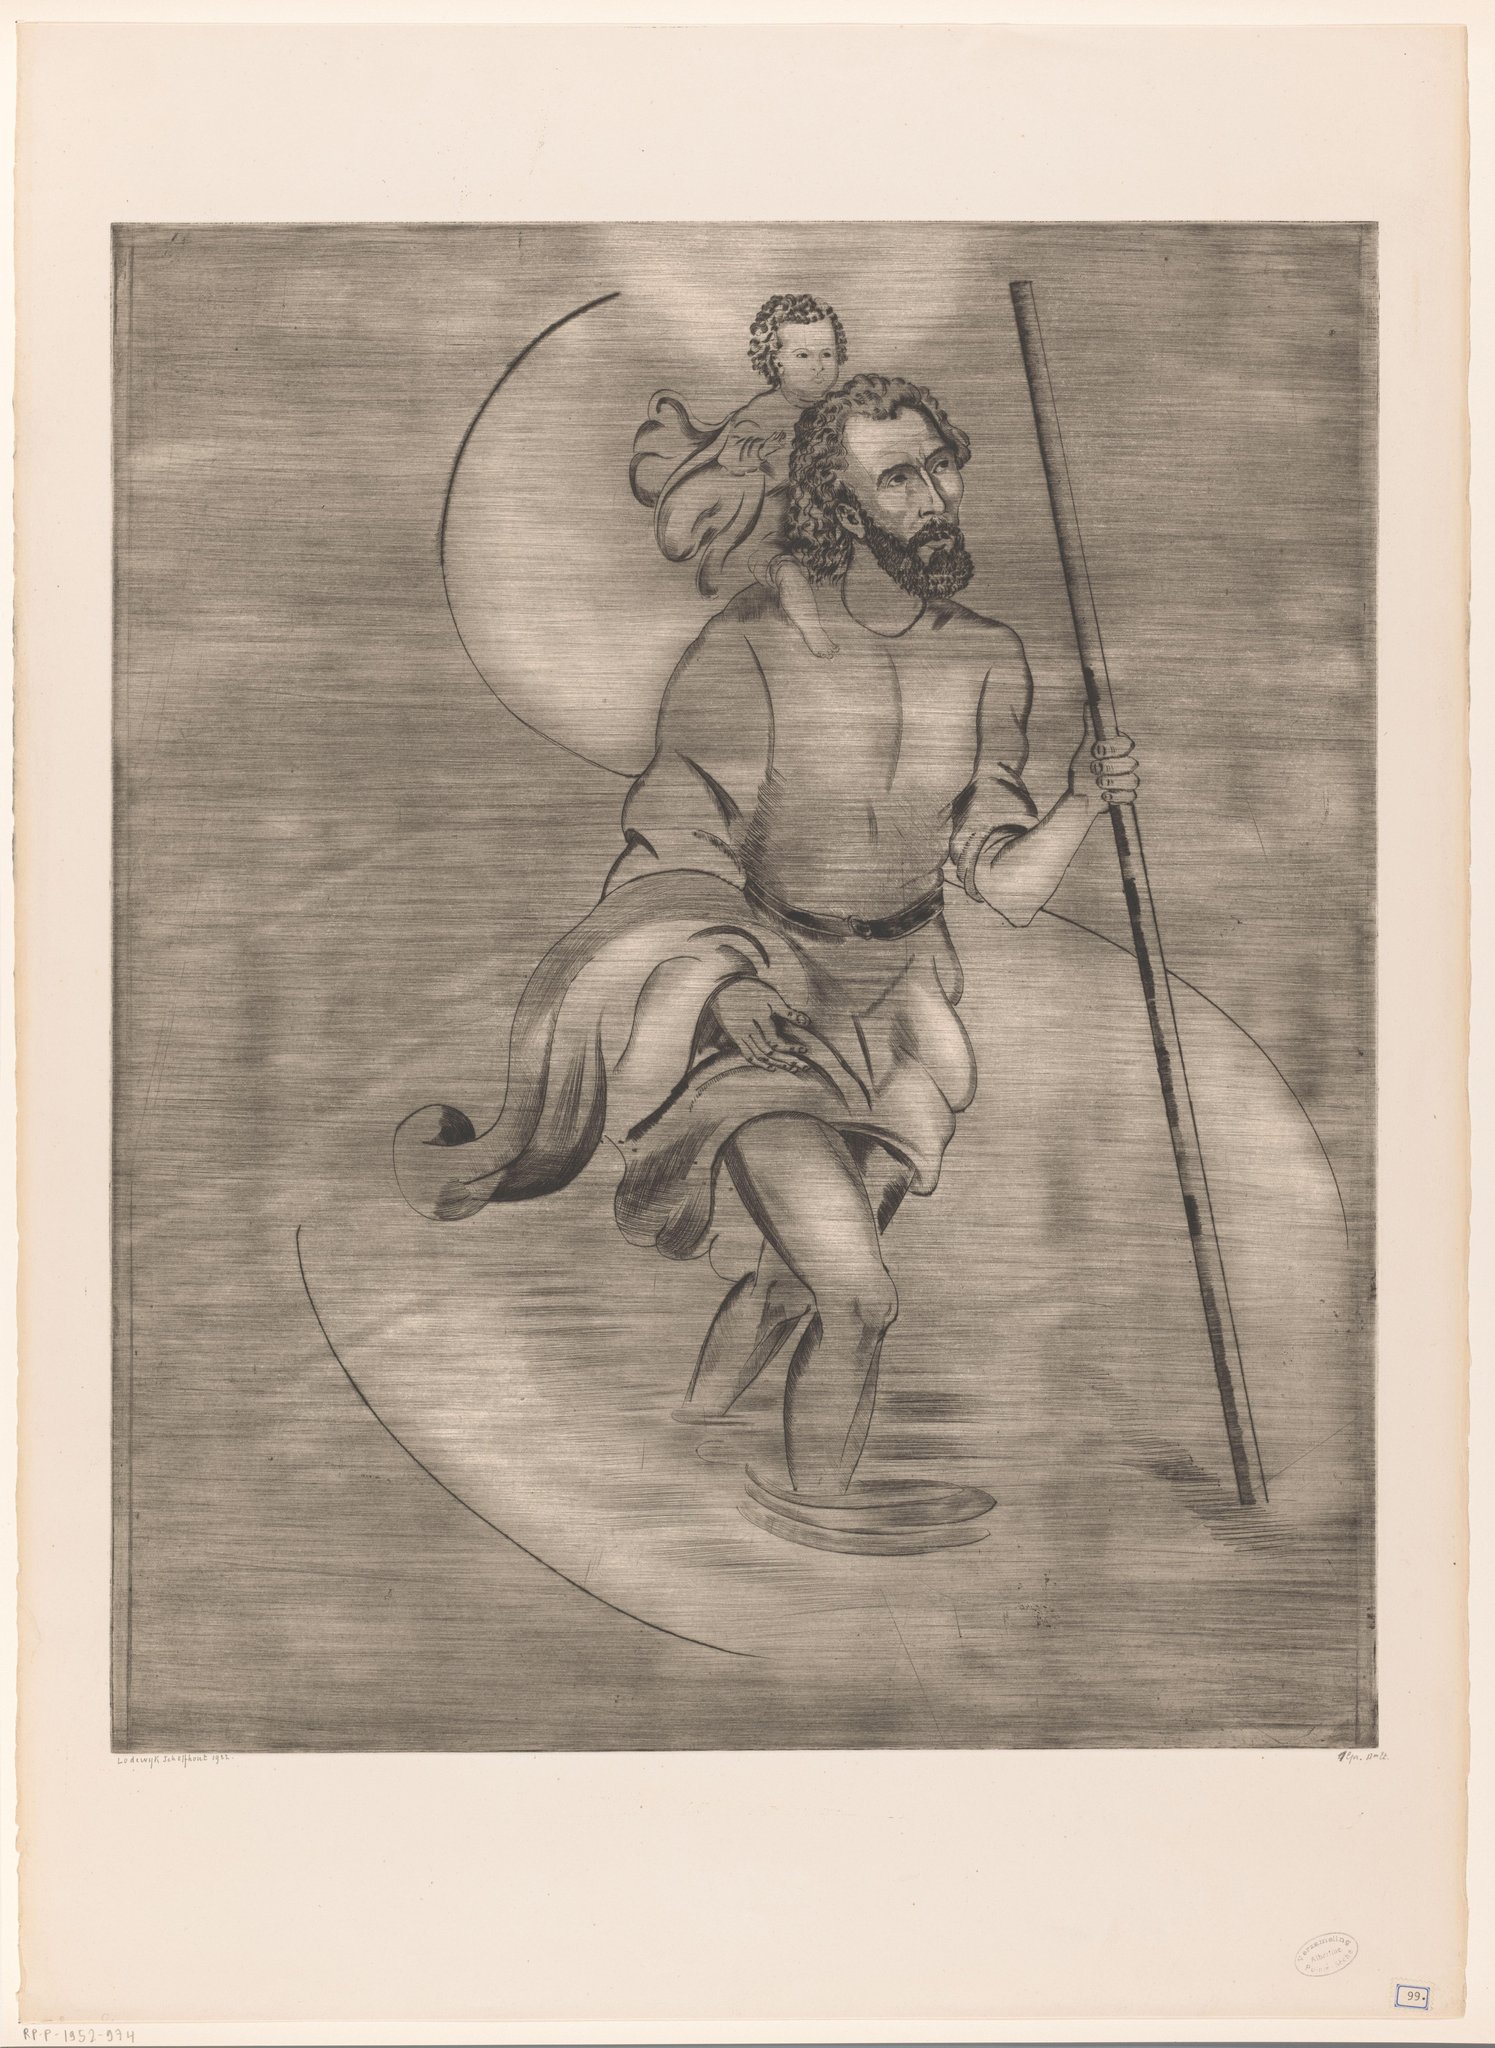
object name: print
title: Saint Christophe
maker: lodewijk schelfhout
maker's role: draughtsman, print maker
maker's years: 1881-1943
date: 1922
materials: paper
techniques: drypoint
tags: st. christopher, with the infant christ on his shoulders, wading through the water and carrying his staff (palm-tree); sometimes a hermit stands on the further bank beside a chapel, a lantern in his hand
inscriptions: collector's mark: Lugt 2228, collector's mark: Lugt 2760, collector's mark: Lugt 5i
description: Christoffel draagt het Christuskind op zijn schouders over het water.